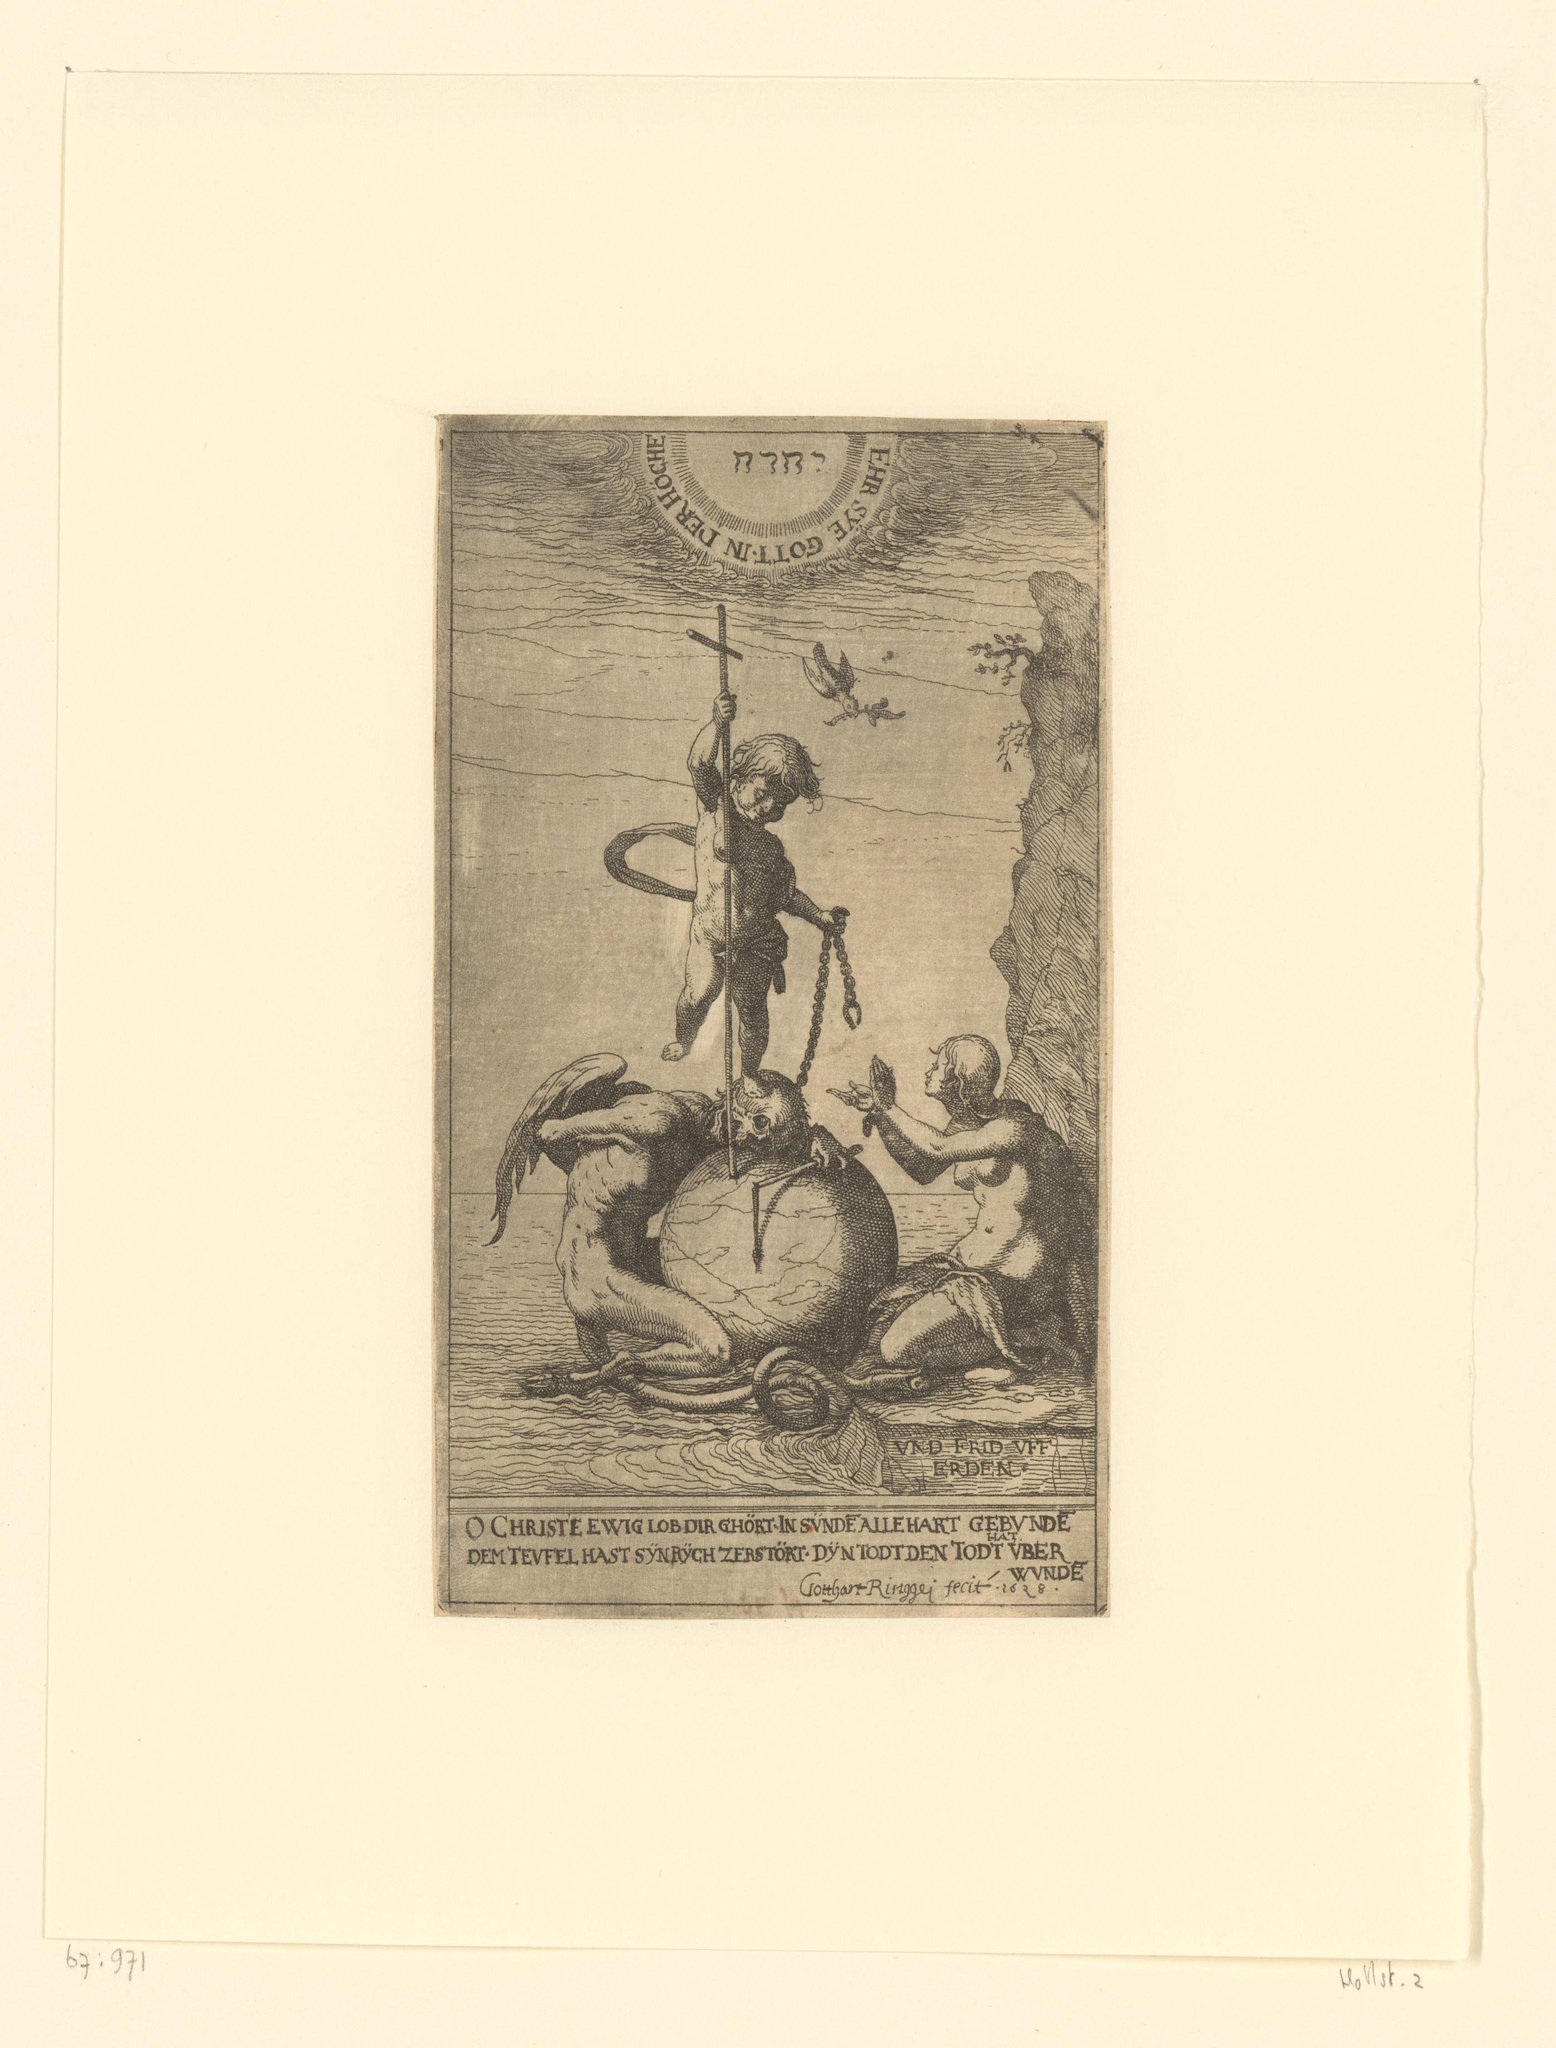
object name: print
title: Allegorie op de door Christus bevrijde wereld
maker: gotthard ringgli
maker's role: print maker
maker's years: 1575-1635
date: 1628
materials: paper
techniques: etching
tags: christ triumphing over devil(s) - dd - christ beardless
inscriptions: collector's mark: Lugt 2228